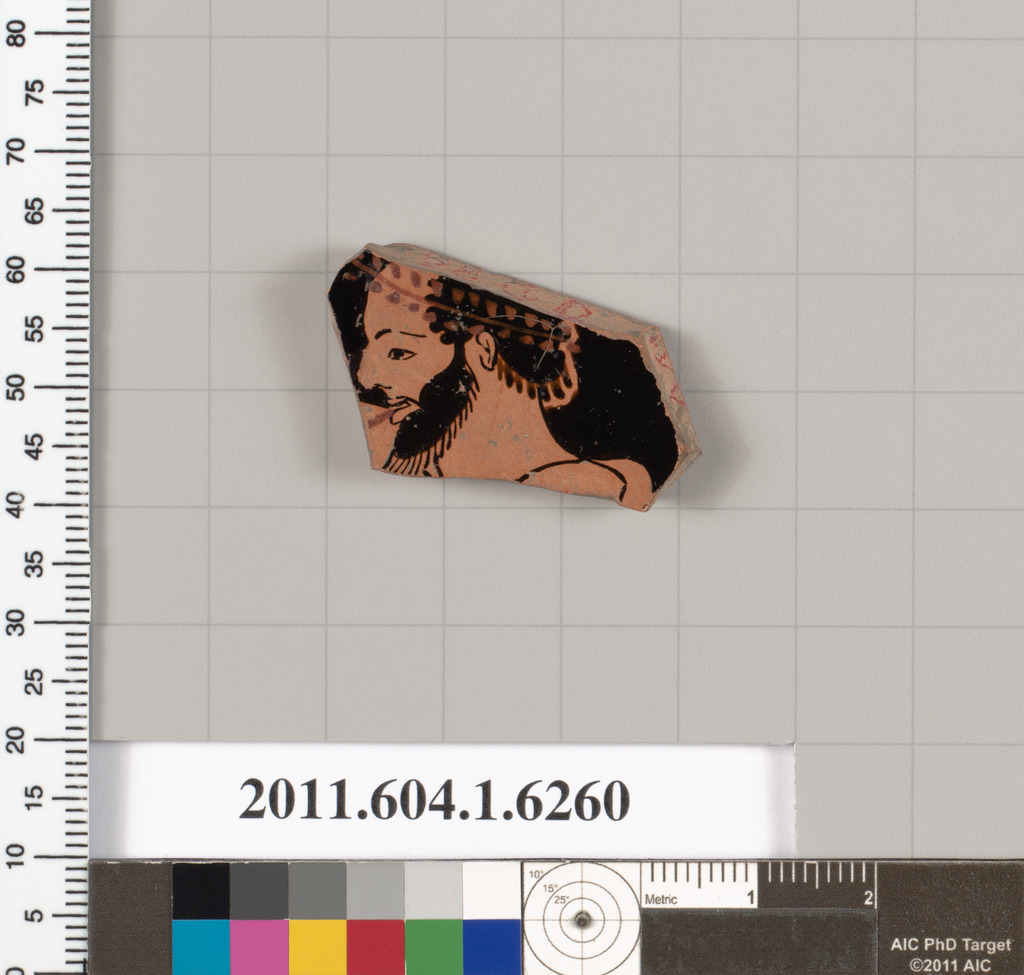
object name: kylix fragment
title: Terracotta fragment of a kylix (drinking cup)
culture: greek, attic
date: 500-480 BCE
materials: terracotta